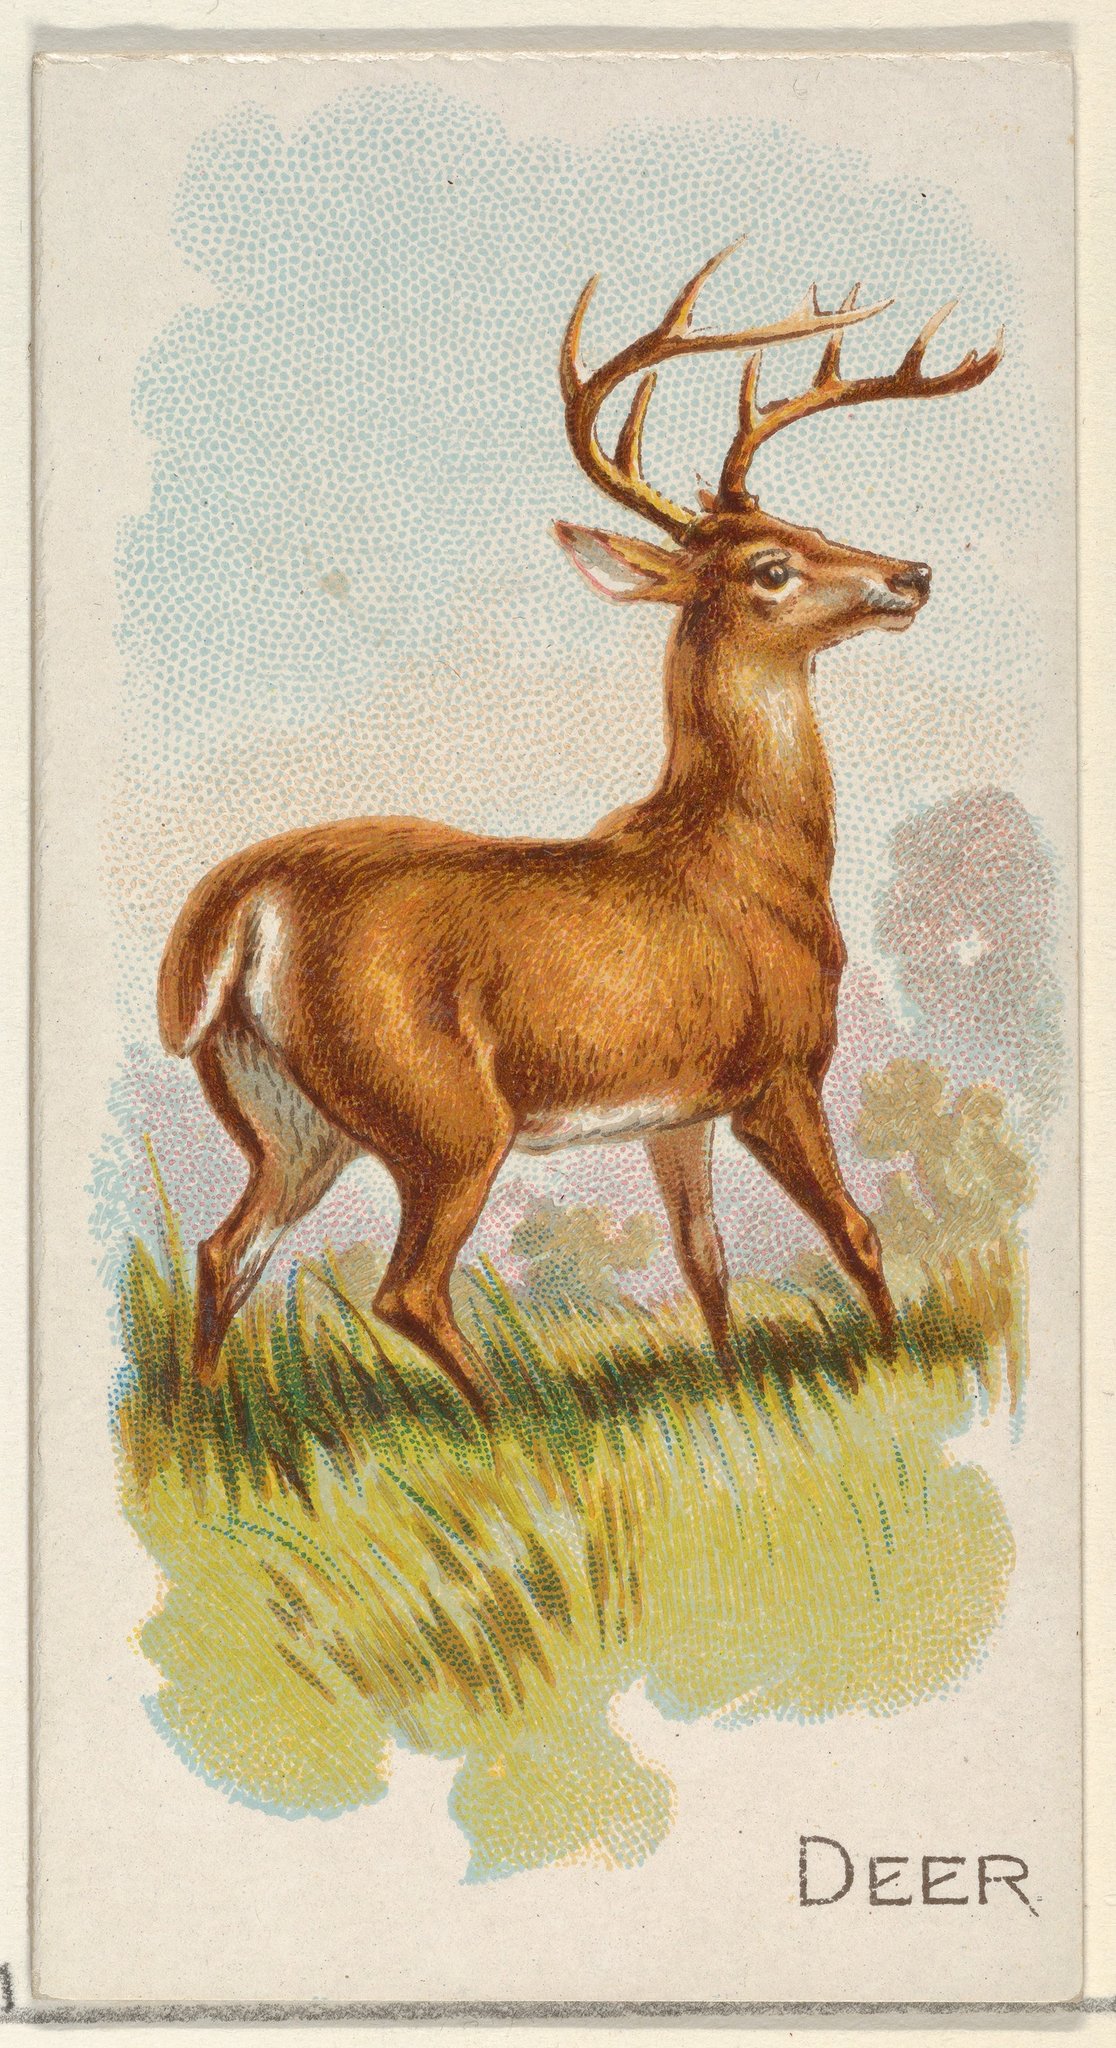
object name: print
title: Deer, from the Quadrupeds series (N21) for Allen & Ginter Cigarettes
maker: allen & ginter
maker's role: publisher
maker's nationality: american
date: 1890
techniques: color lithograph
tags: deer